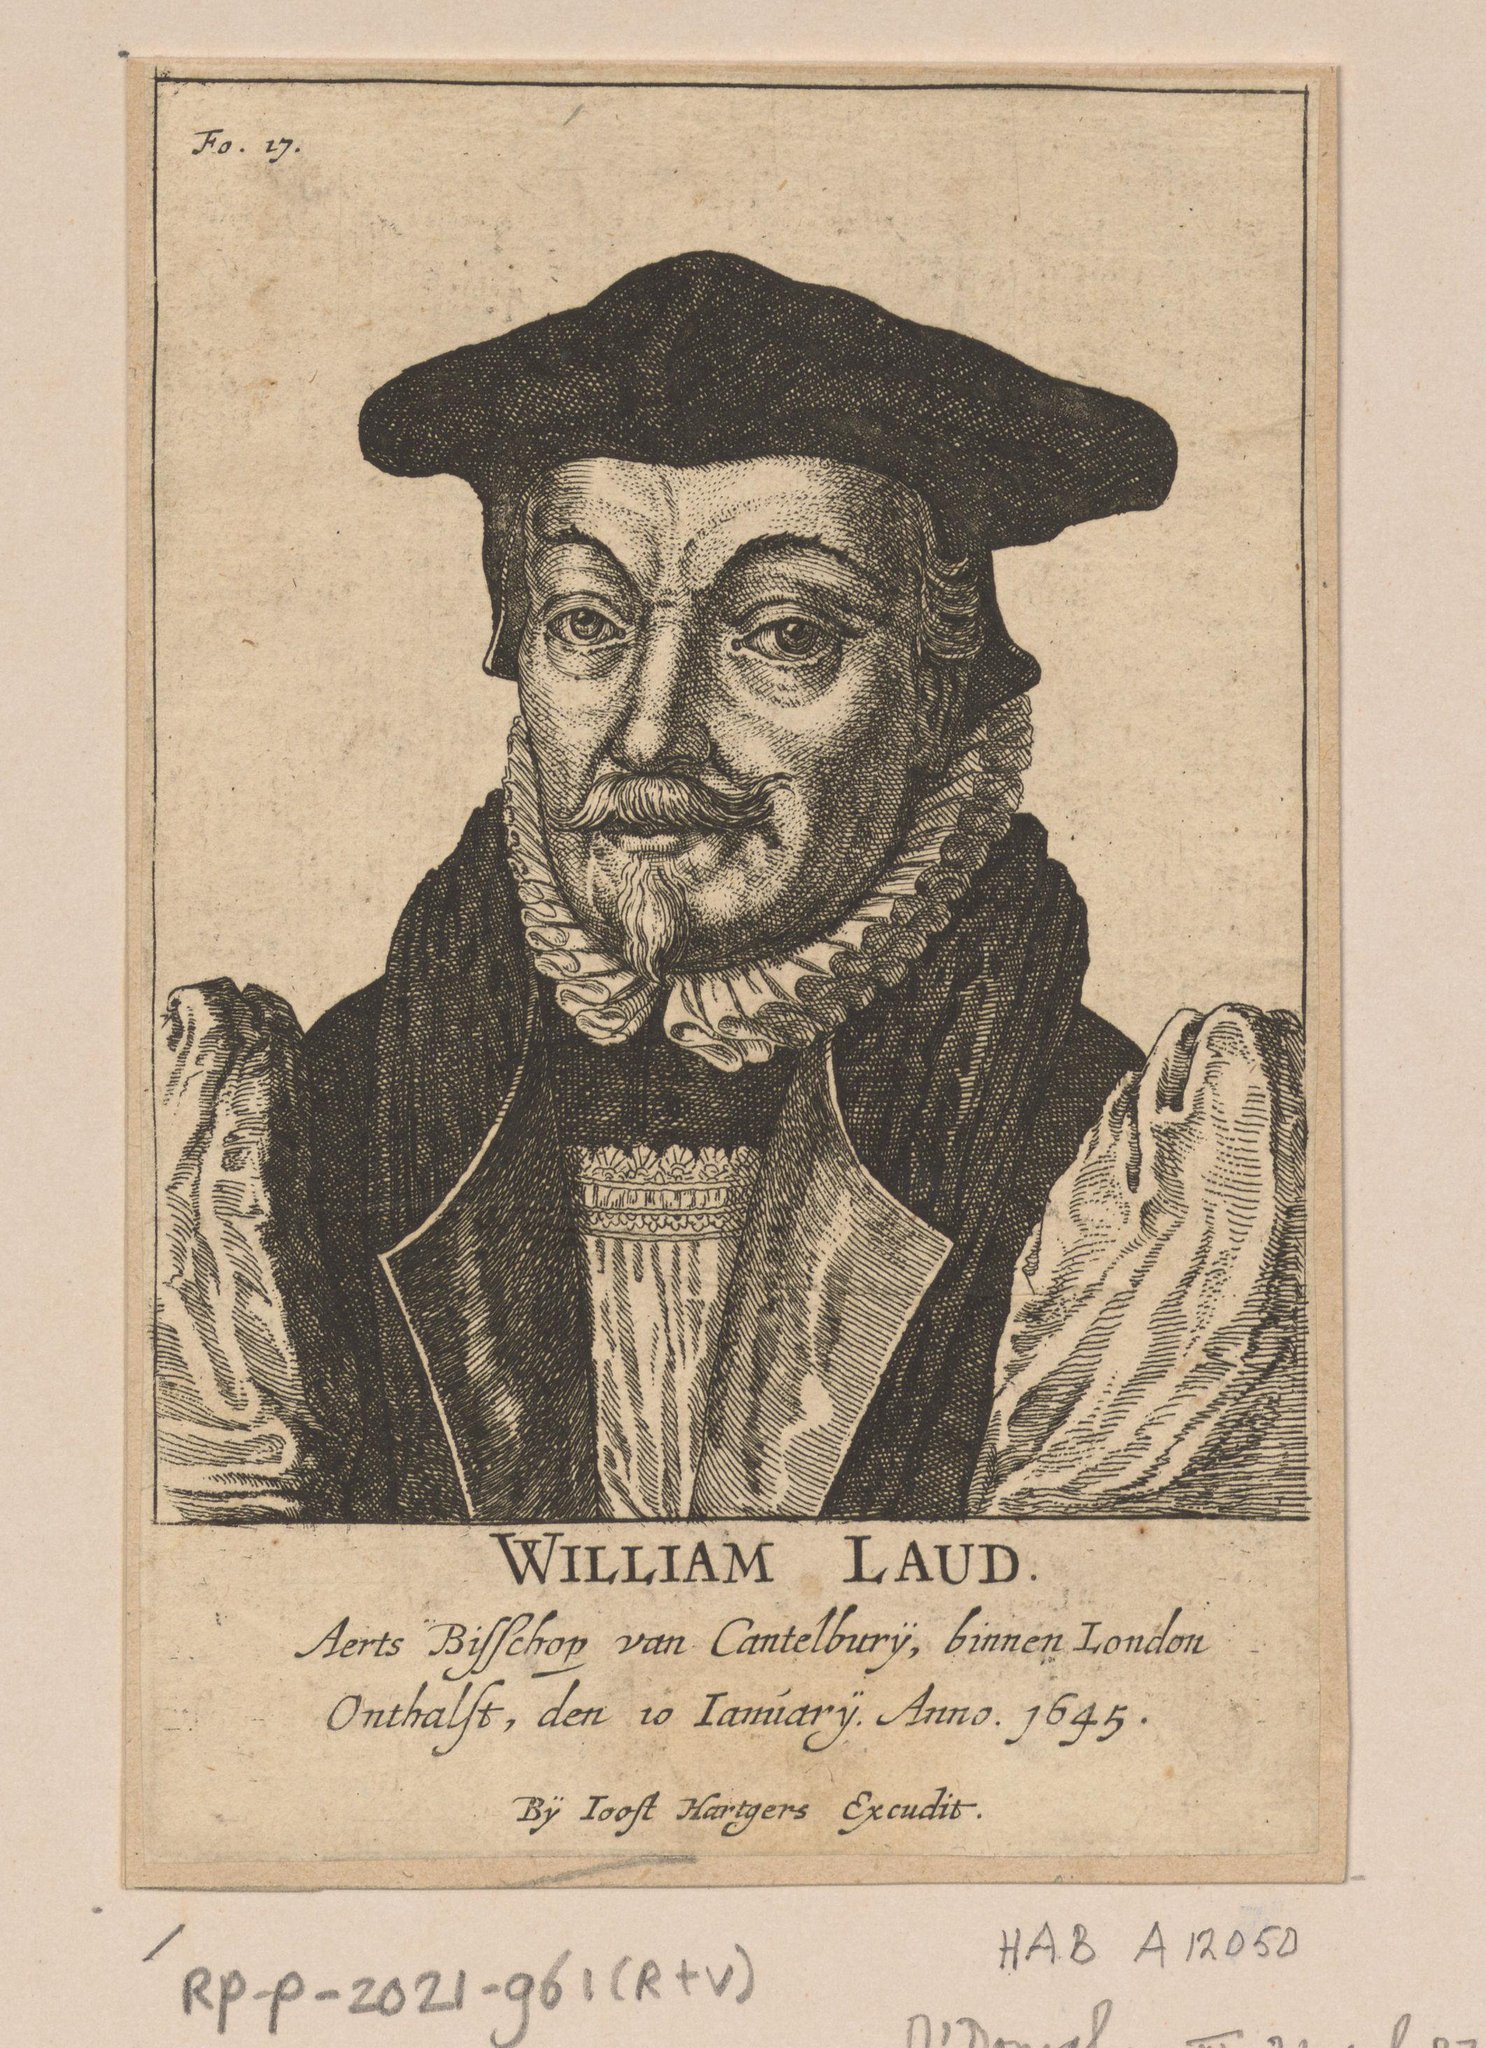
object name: print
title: Portret van William Laud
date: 1649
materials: paper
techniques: engraving, etching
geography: northern netherlands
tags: london, historical persons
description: Prent waarschijnlijk uit: Vermeerdert Engelandts Memoriael (...). Amsterdam: Joost Hartgers, 1649.